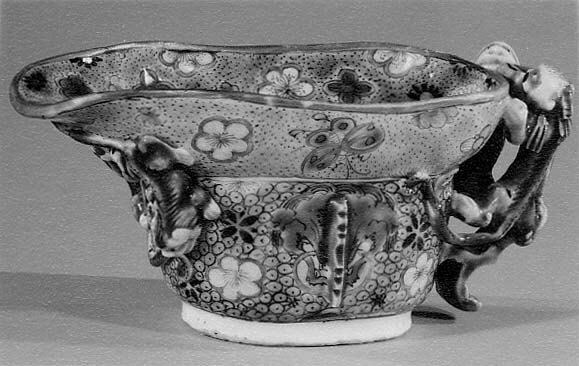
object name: cup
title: Libation Cup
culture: chinese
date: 1667-1733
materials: enamel, porcelain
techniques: painting, polychrome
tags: butterflies,flowers